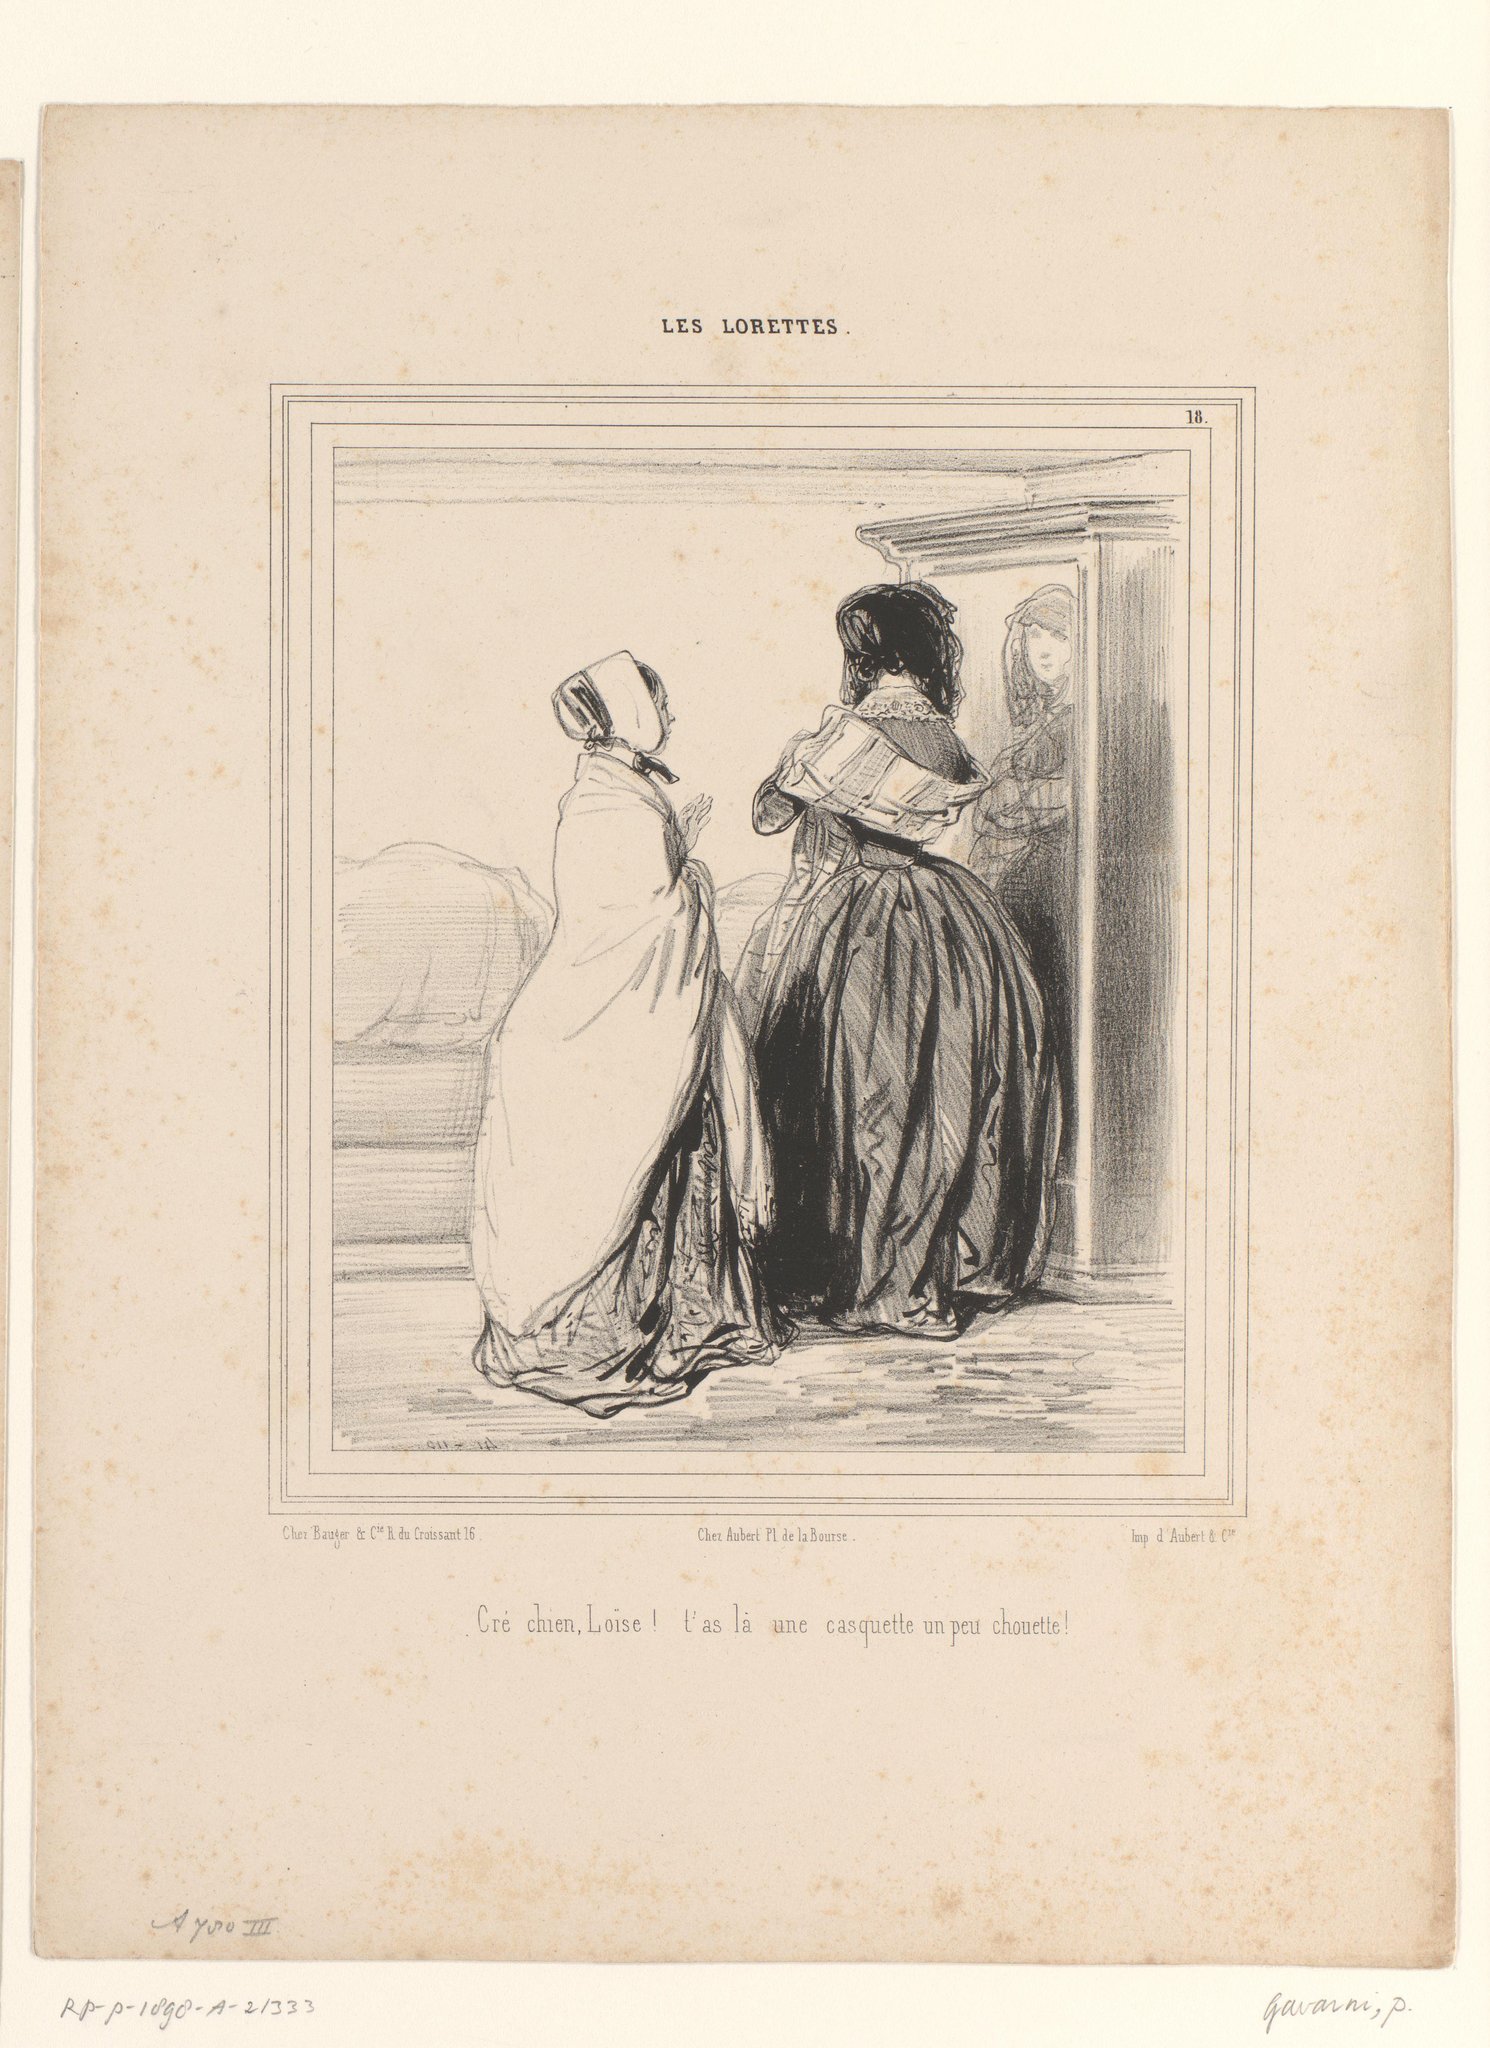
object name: print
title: Cré chien, Loïse! t'as là une casquette un peu chouette!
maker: paul gavarni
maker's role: draughtsman, print maker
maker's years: 1804-1866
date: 1841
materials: paper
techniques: lithograph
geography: paris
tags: looking in the mirror; (possibly: contemplation of own beauty - aa - (for) women), head-gear: cap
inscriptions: check stamp: Lugt 3855, collector's mark: Lugt 964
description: Prent gebruikt voor: Le Charivari, 21 december 1841.